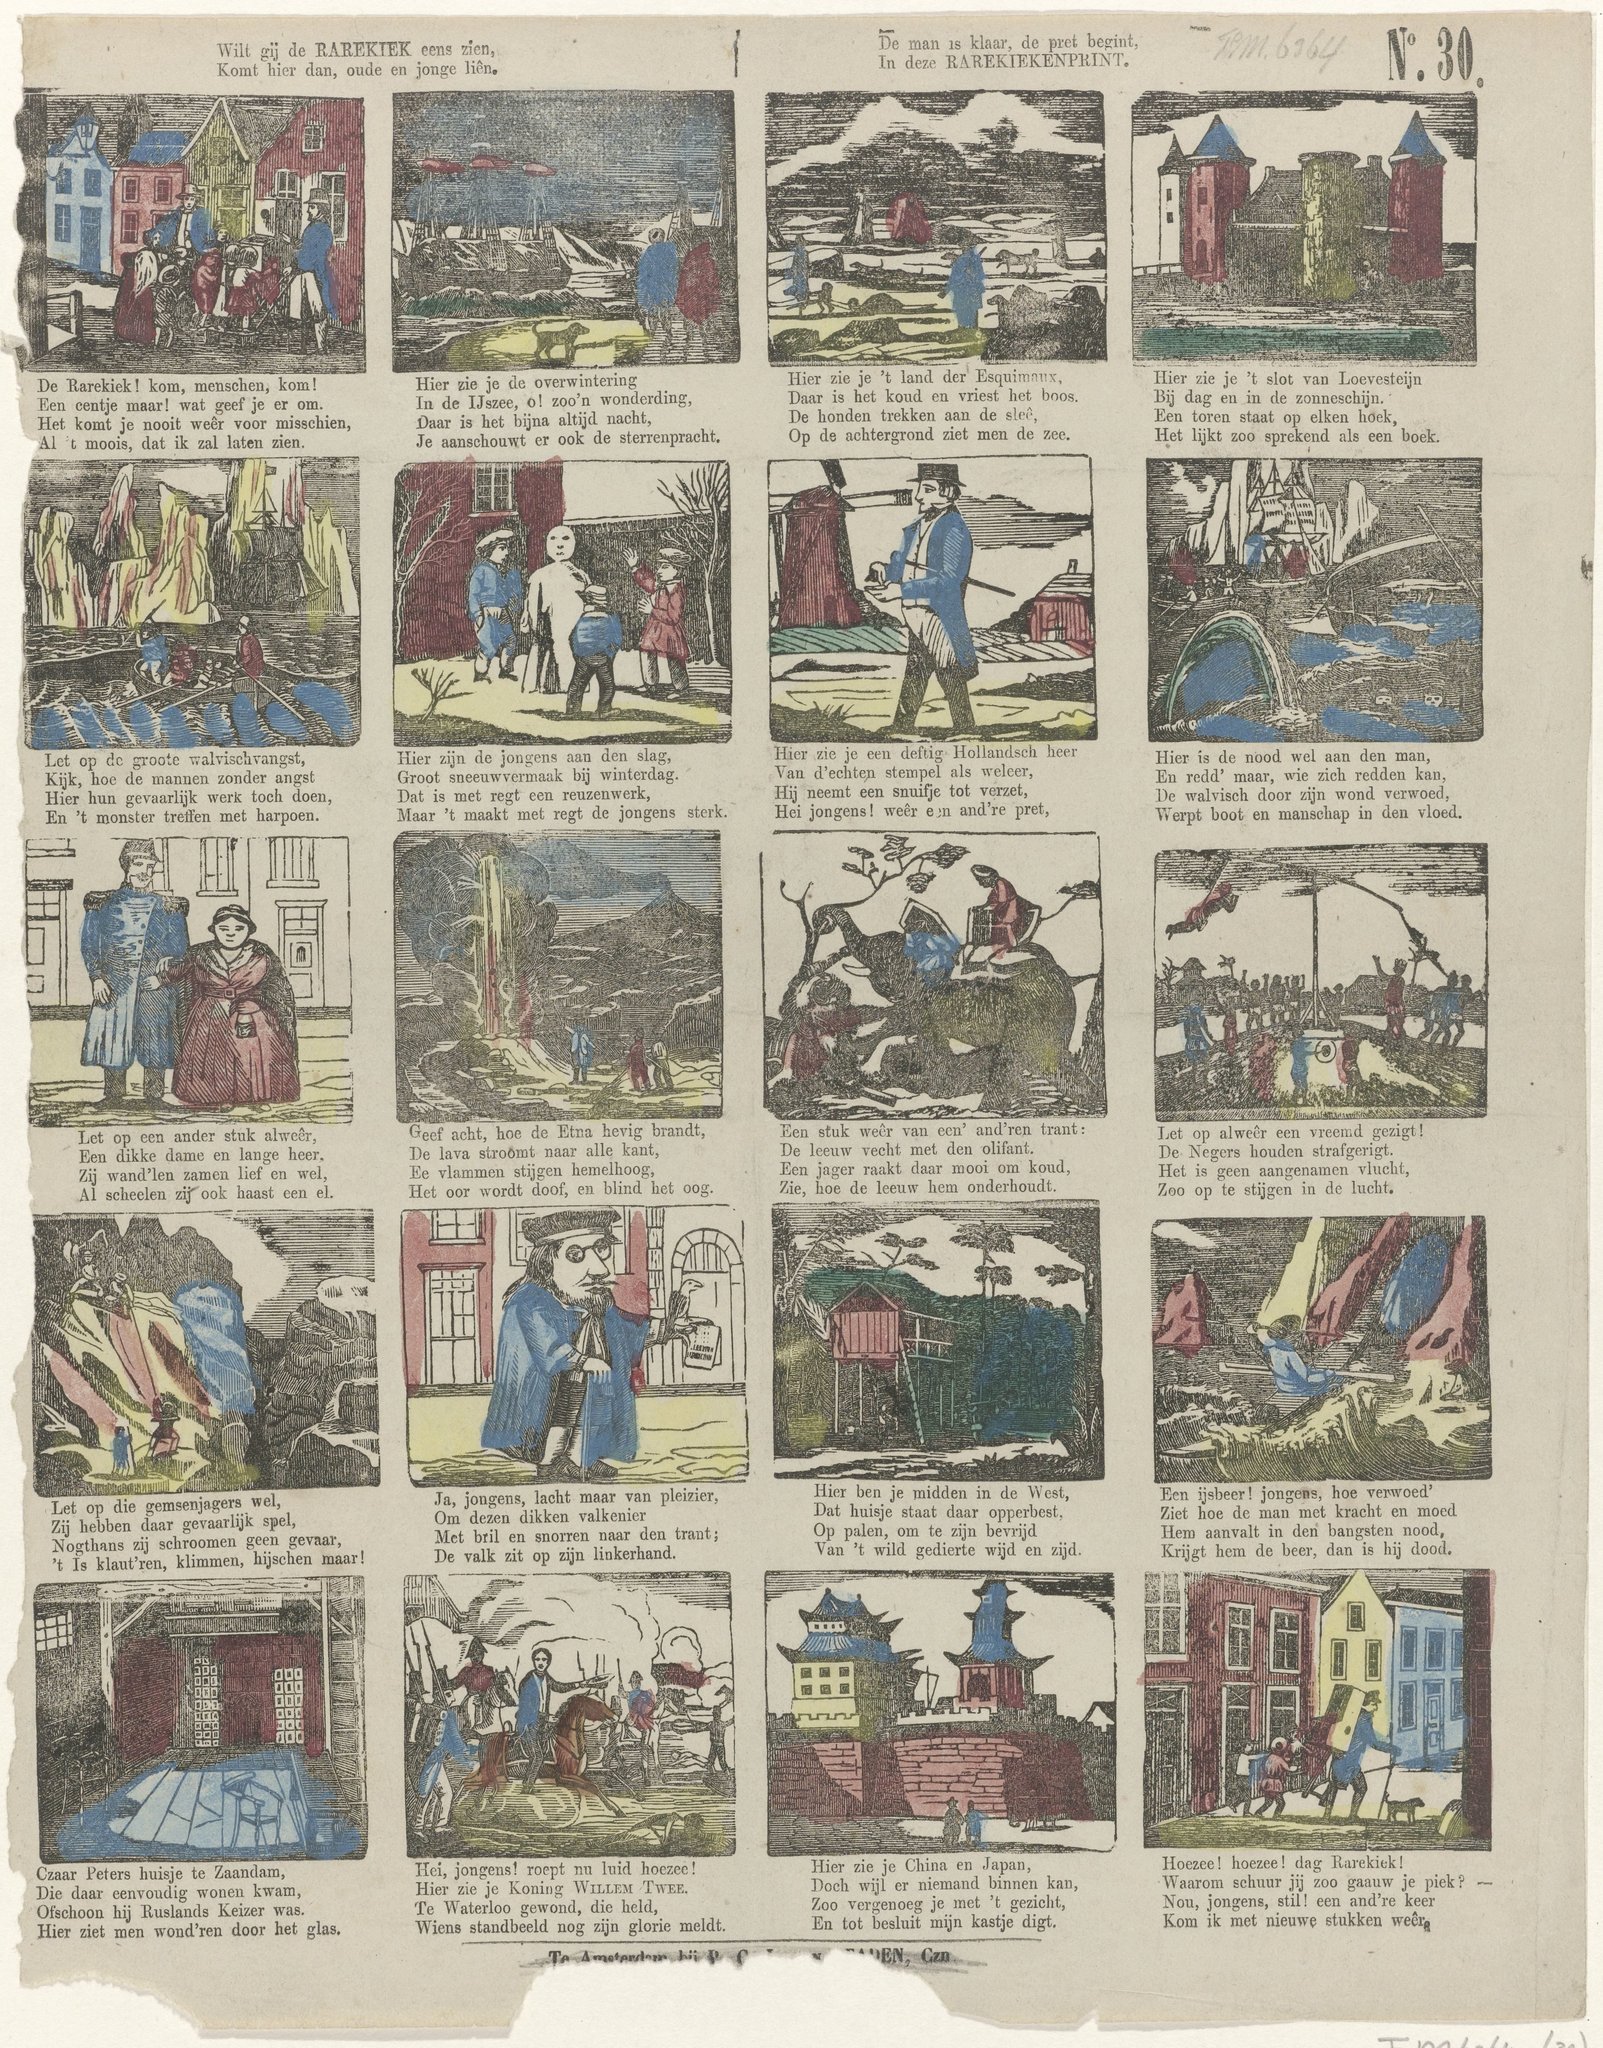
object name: print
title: Wilt gij de Rarekiek eens zien, / Komt hier dan, oude en jonge liên. / De man is klaar, de prent begint, / In deze Rarekiekenprint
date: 1850-1870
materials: paper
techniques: colour, letterpress printing, engraving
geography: netherlands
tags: street-trader, peep-show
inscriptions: collector's mark: Lugt 2228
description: Blad met twintig voorstellingen vertoond door de rarekiek. Het eerste en het laatste plaatje tonen het begin en het einde van de voorstelling. Onder elk plaatje een vierregelig versje. Genummerd rechtsboven: No. 30. Ca. 1800-1850.